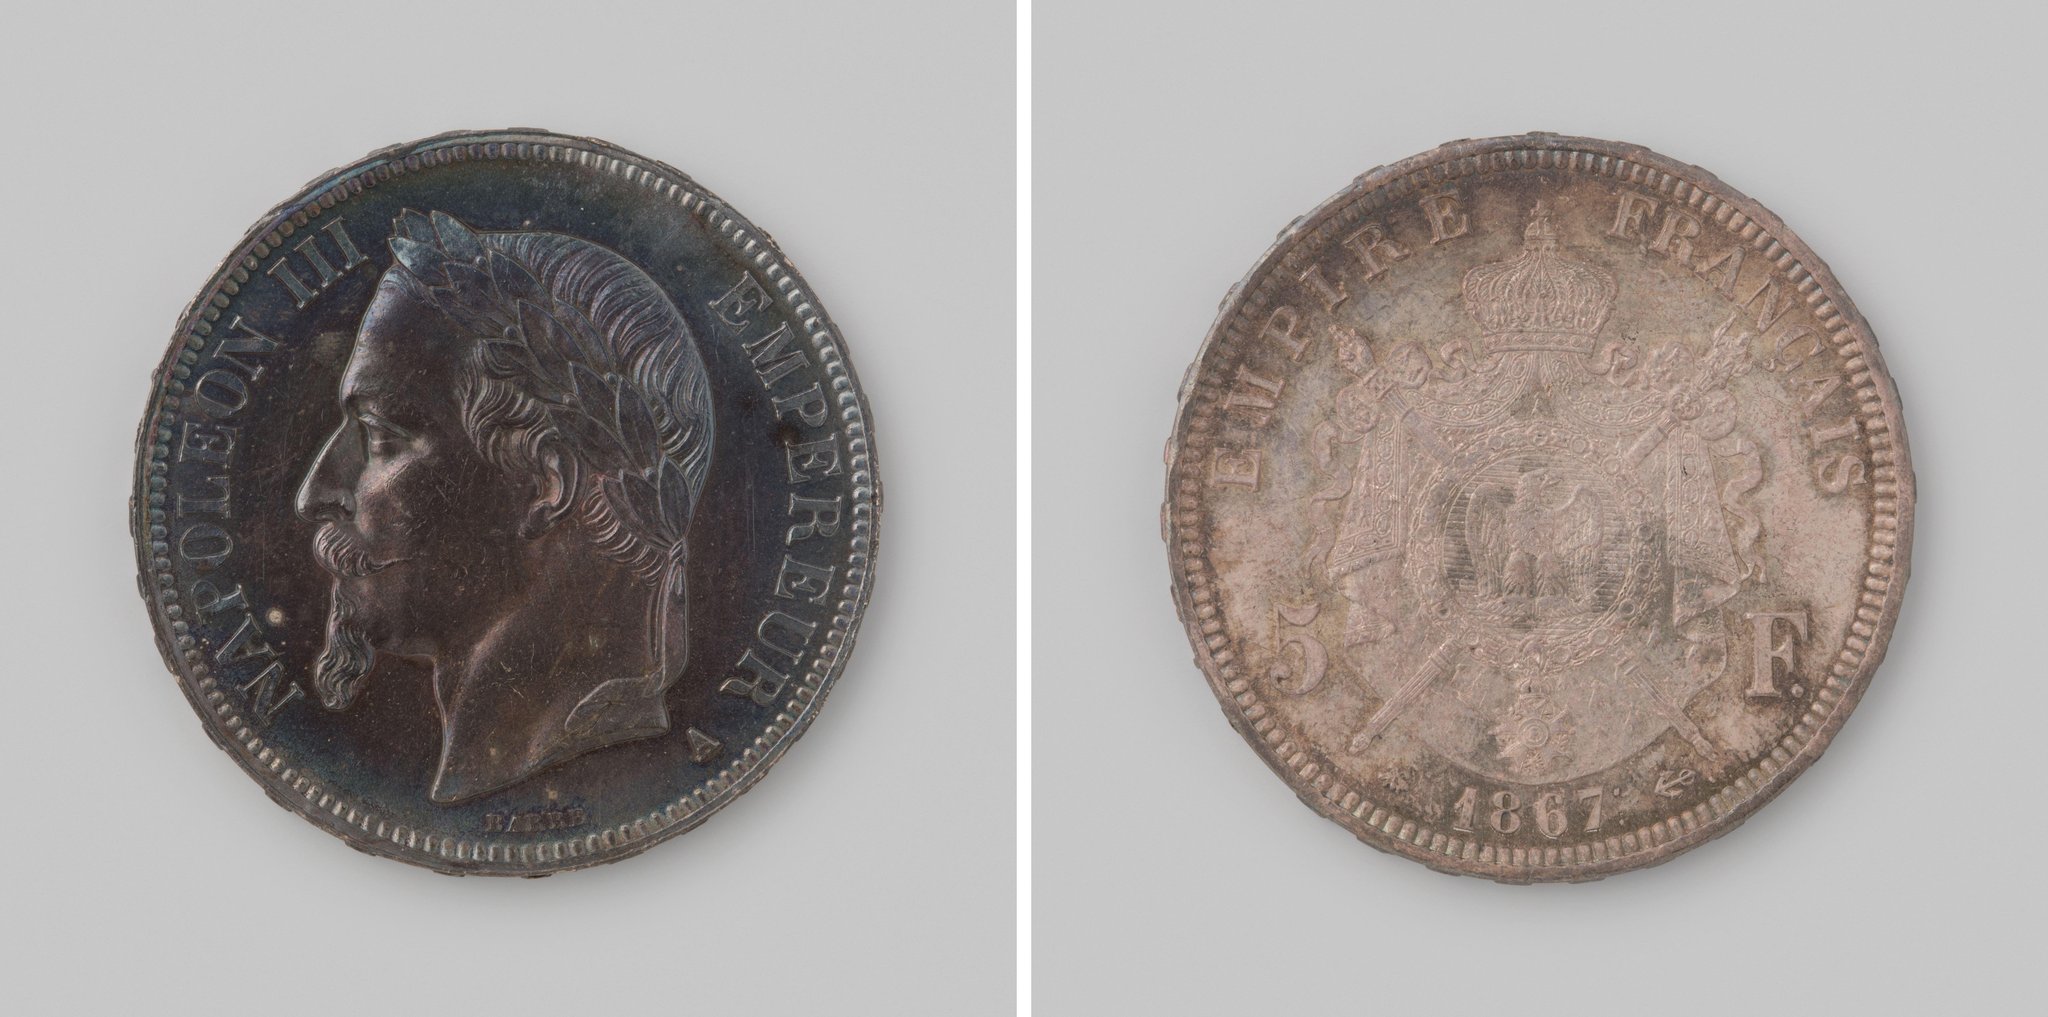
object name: coin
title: Keizerrijk Frankrijk, Napoleon III, 5 francs,1867 A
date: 1867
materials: silver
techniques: striking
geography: paris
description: Zilveren munt. Voorzijde: gelauwerd hoofd van de keizer naar links. Rechts onderaan de letter A [=Parijs]. Keerzijde: tussen waarde-aanduiding gekroonde mantel, waarop door keten van ridderorde met juweel omhangen rond wapenschild, waarachter twee gekruiste staven. Onderaan jaartal. Opliggend randschrift.